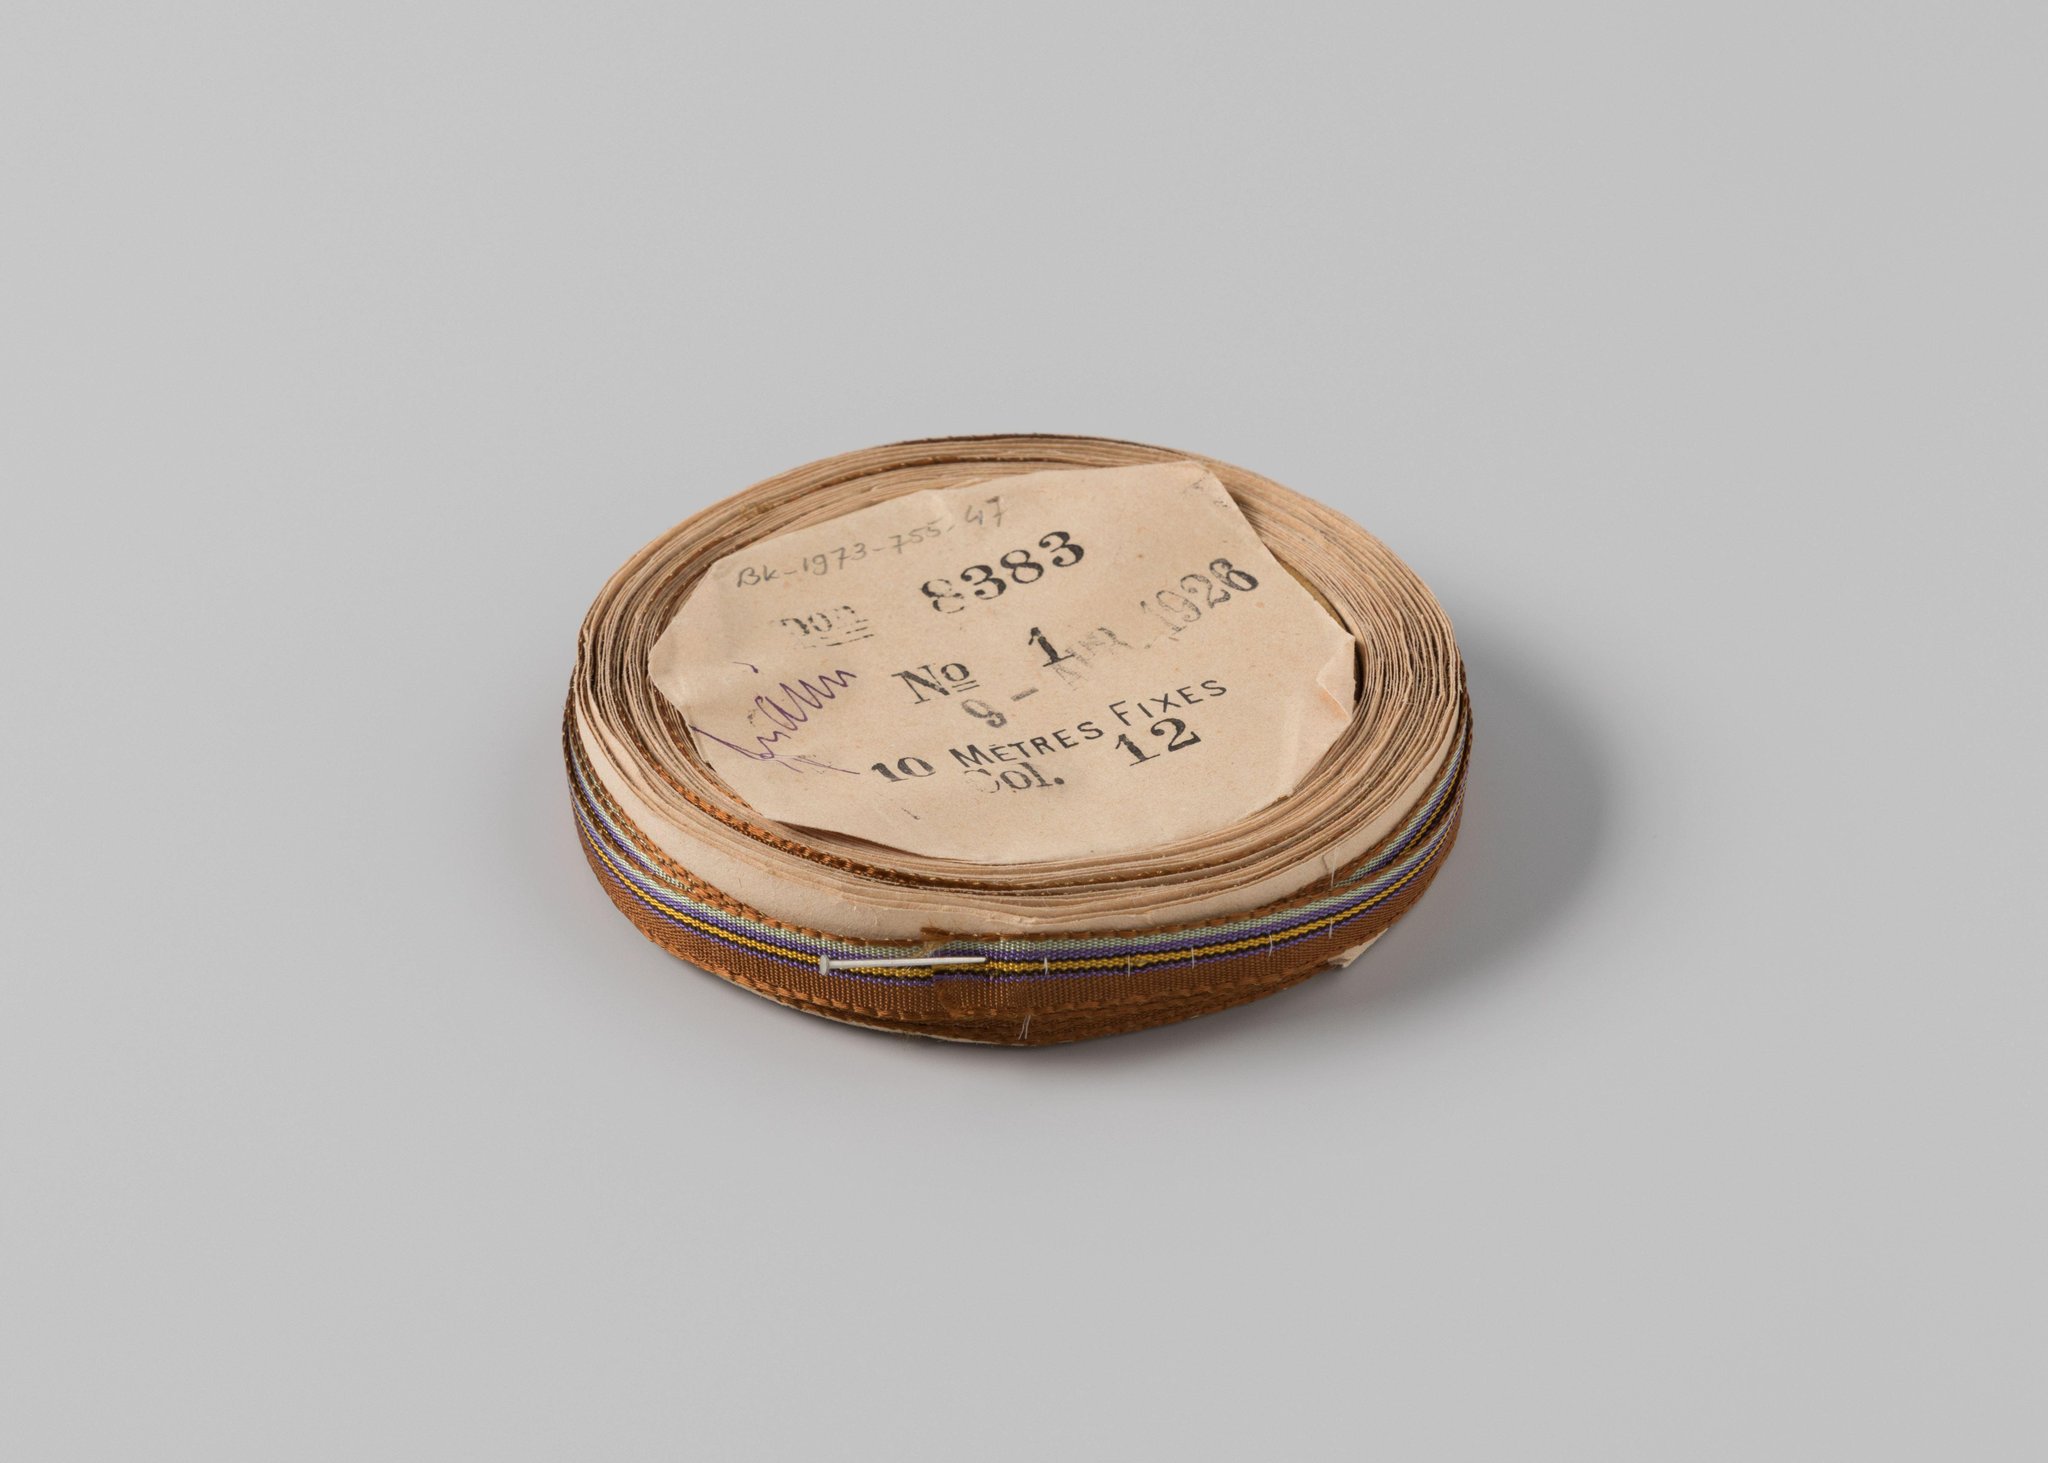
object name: ribbon material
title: Lint op rol, gestreept, bruin met lila, zwart, lichtgroen en oranje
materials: cardboard, paper, textile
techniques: weave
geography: france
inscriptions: number: ‘Pon 8383’, stamp: ‘9 - APR. 1926’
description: Lint op rol, gestreept, bruin met lila, zwart, lichtgroen en oranje.